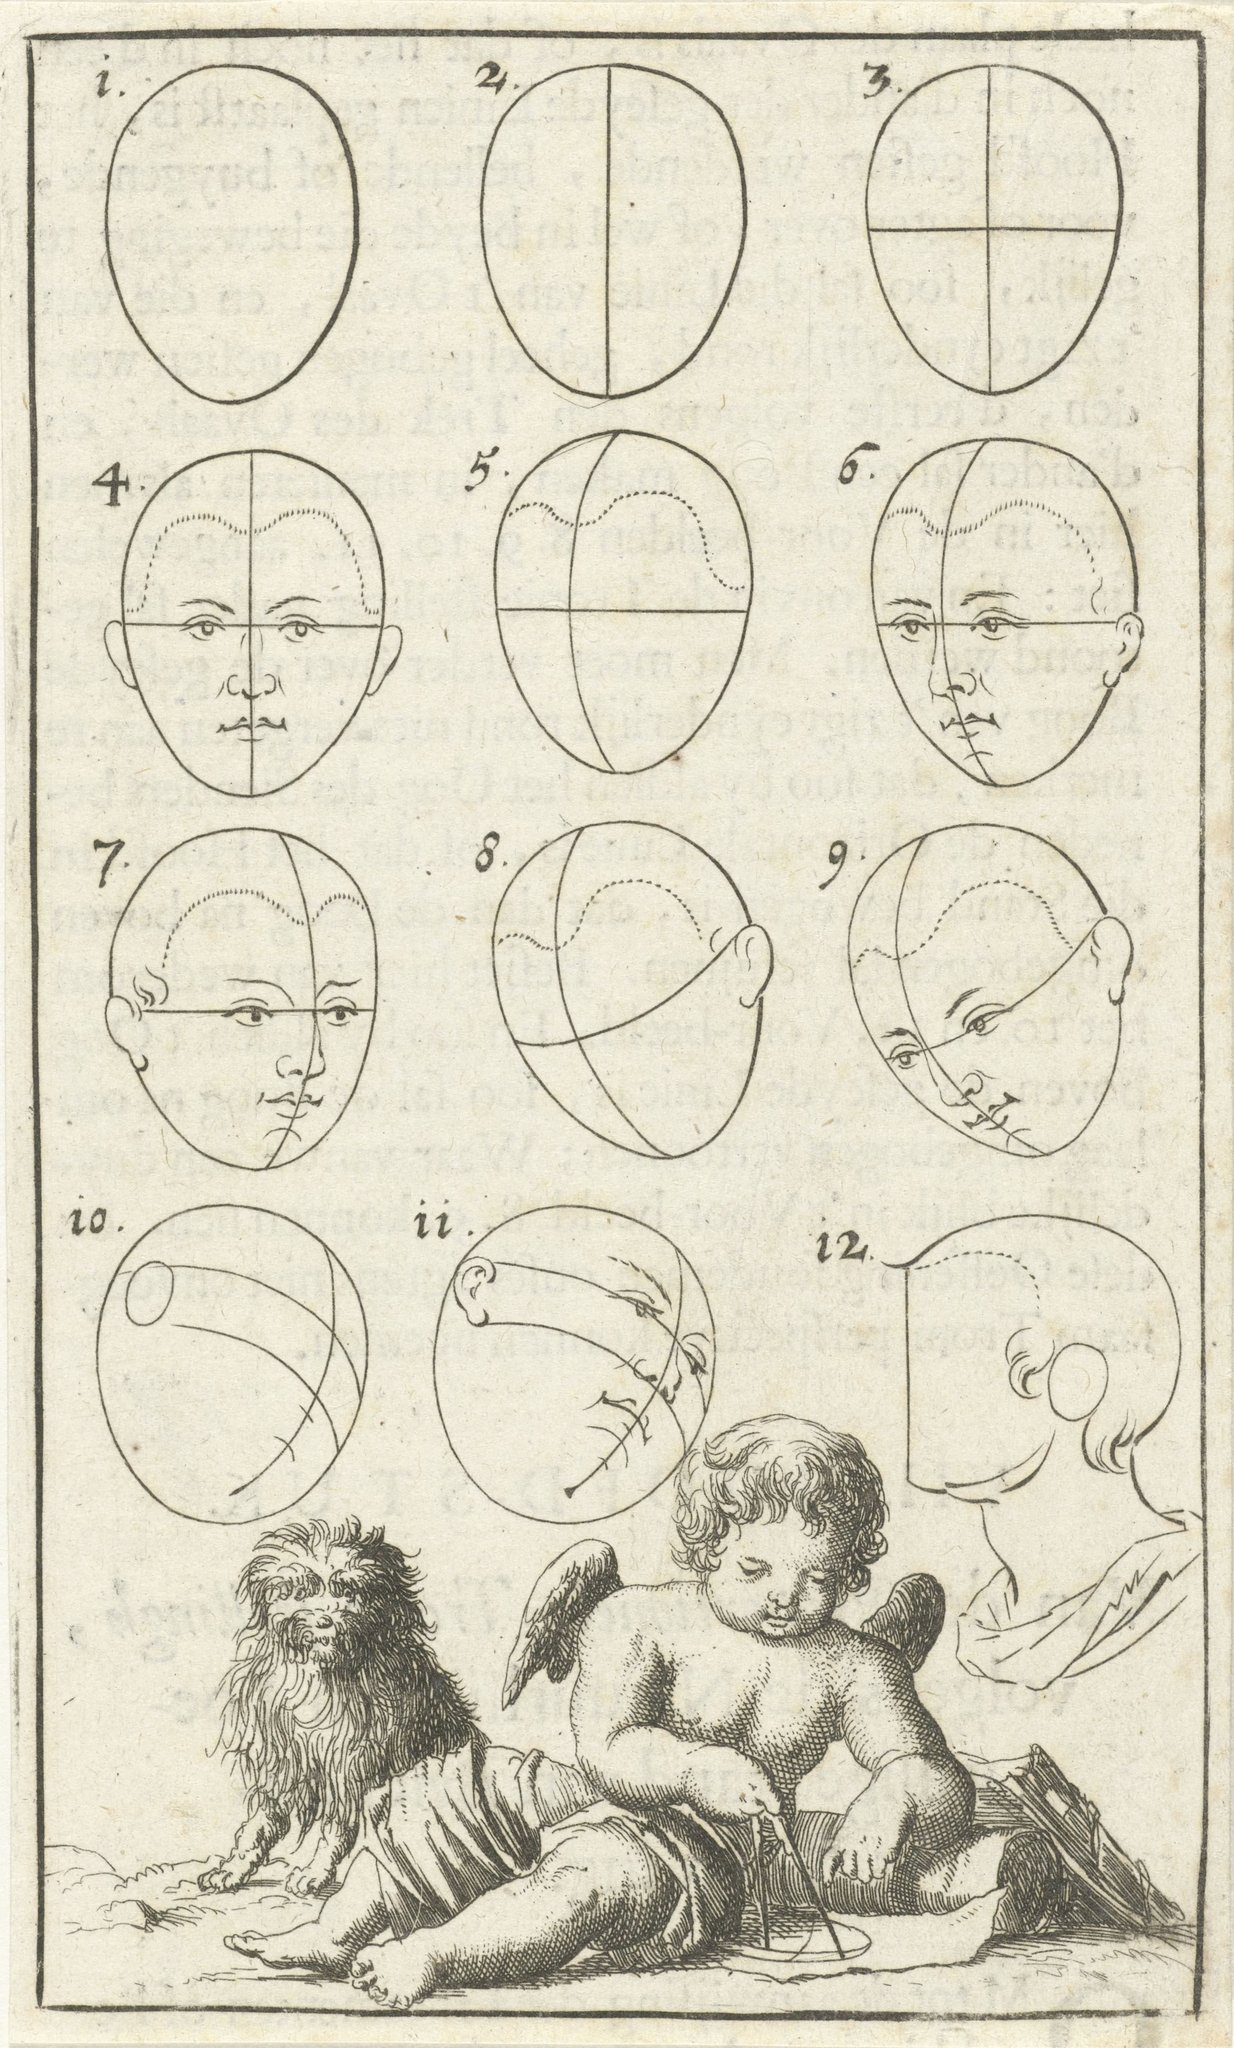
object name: book illustration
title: Twaalf hoofden in verschillende standen, gemerkt 1-12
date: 1682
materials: paper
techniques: etching, letterpress printing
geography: amsterdam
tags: head (human), angels, dog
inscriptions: collector's mark: Lugt 2228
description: Illustratie opgenomen in: Goeree, Wilhelmus. Natuurlyk en schilderkonstig ontwerp der menschkunde, p. 220. Amsterdam: Wilhelmus Goeree (I), 1682.